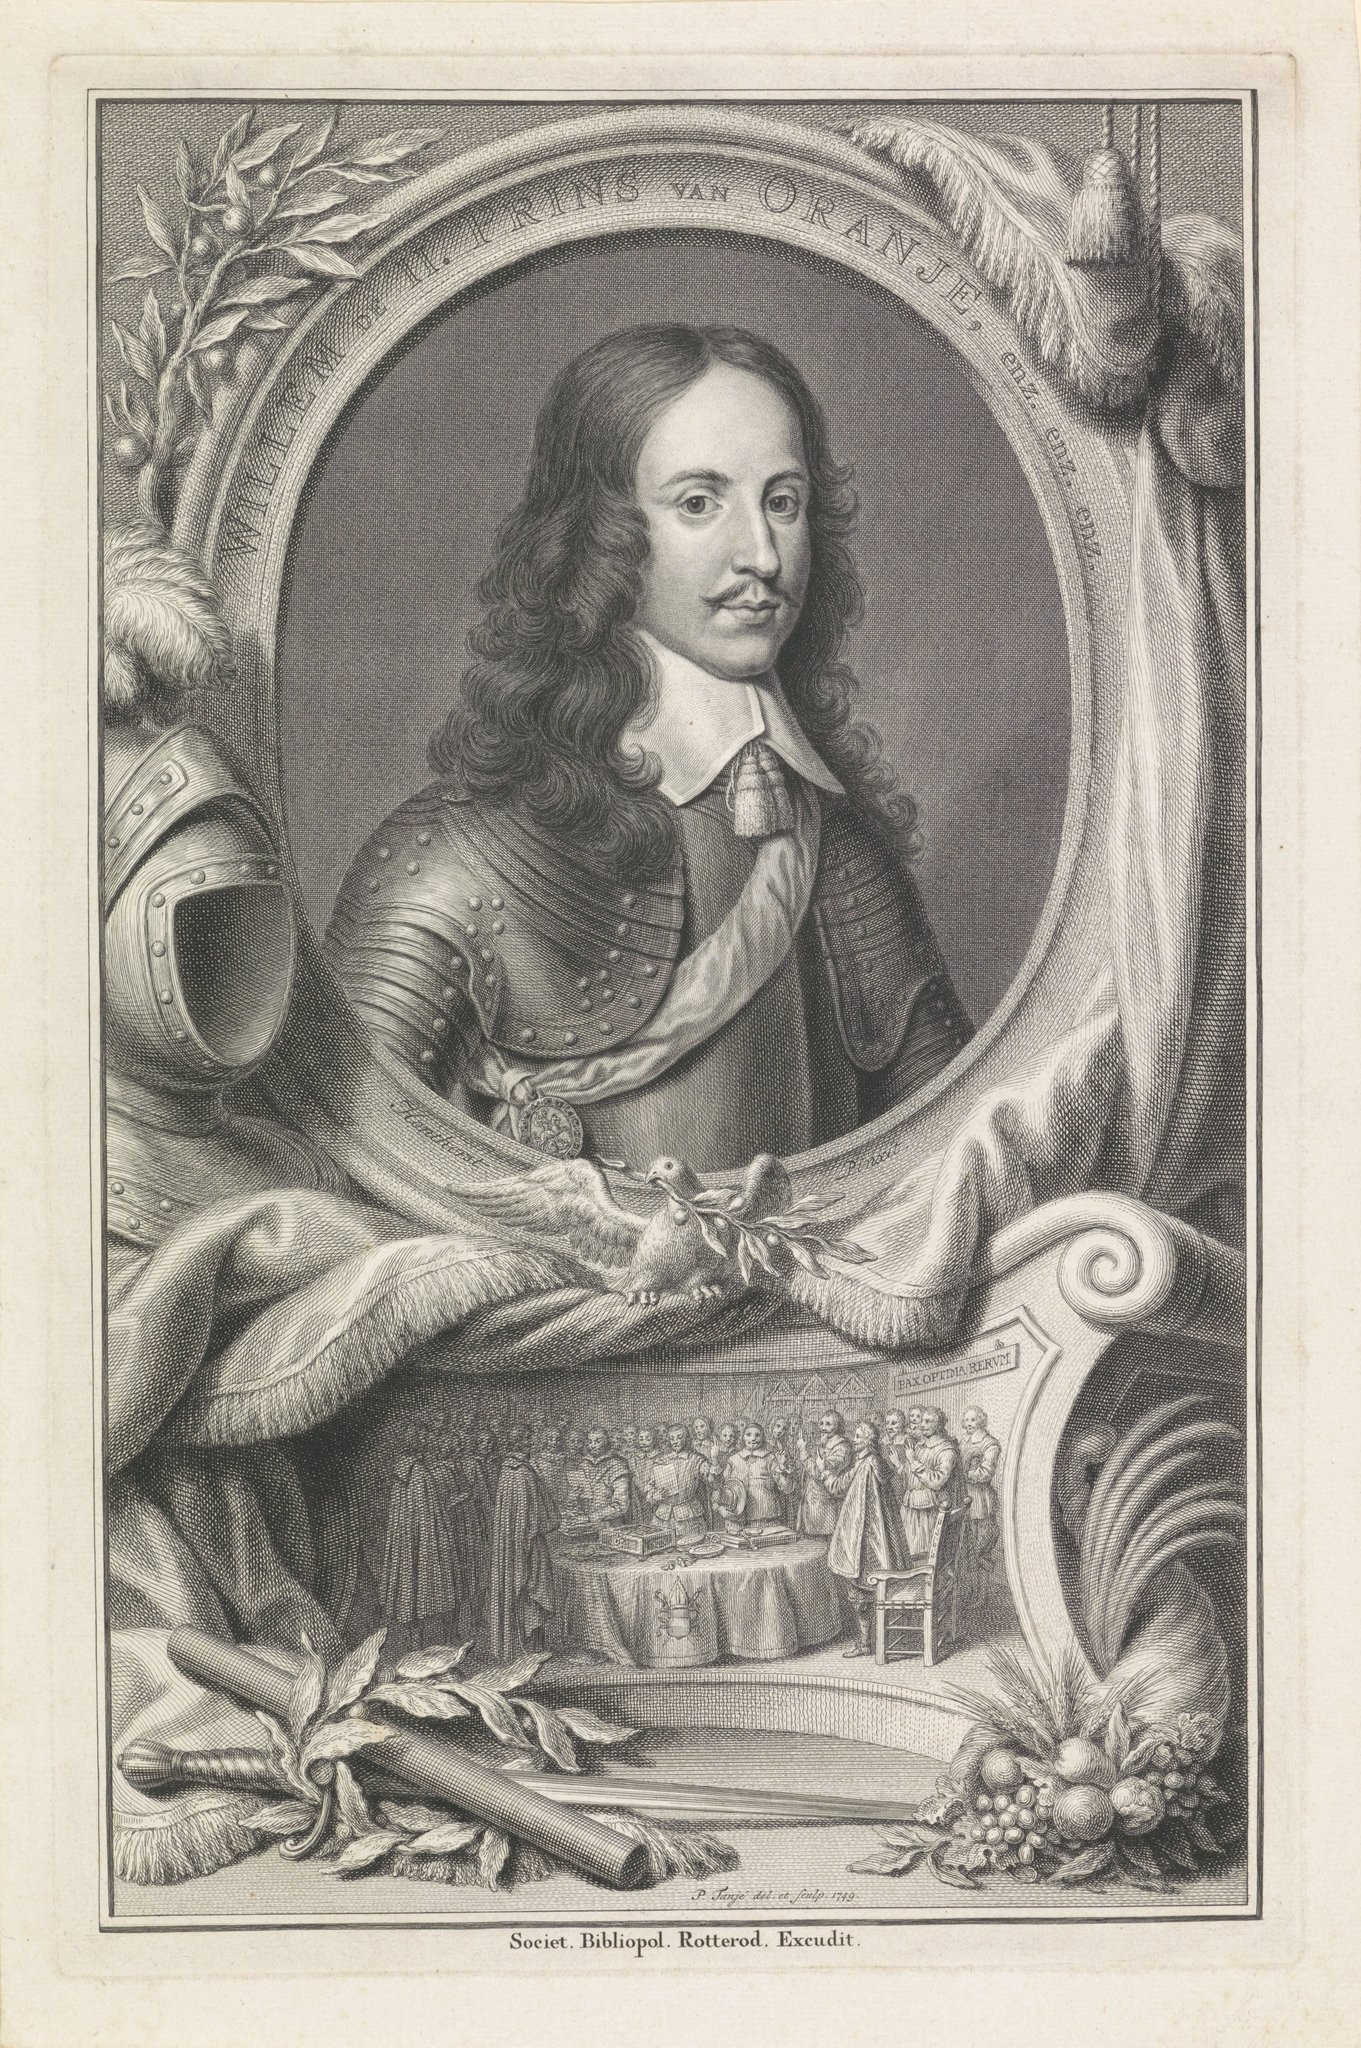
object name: print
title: Portret van Willem II, prins van Oranje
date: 1749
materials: paper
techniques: engraving, etching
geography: amsterdam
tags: william ii (prince of orange), knighthood order (garter) - insignia of a knighthood order, e.g.: badge, chain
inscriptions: collector's mark: Lugt 963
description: Portret van Willem II in een ovaal met randschrift. Rondom ligt een aantal allegorische objecten, waaronder een commandostaf, een lauwerkrans en een helm. Op het reliëf het beëdigen van de Vrede van Munster, 15 mei 1648.